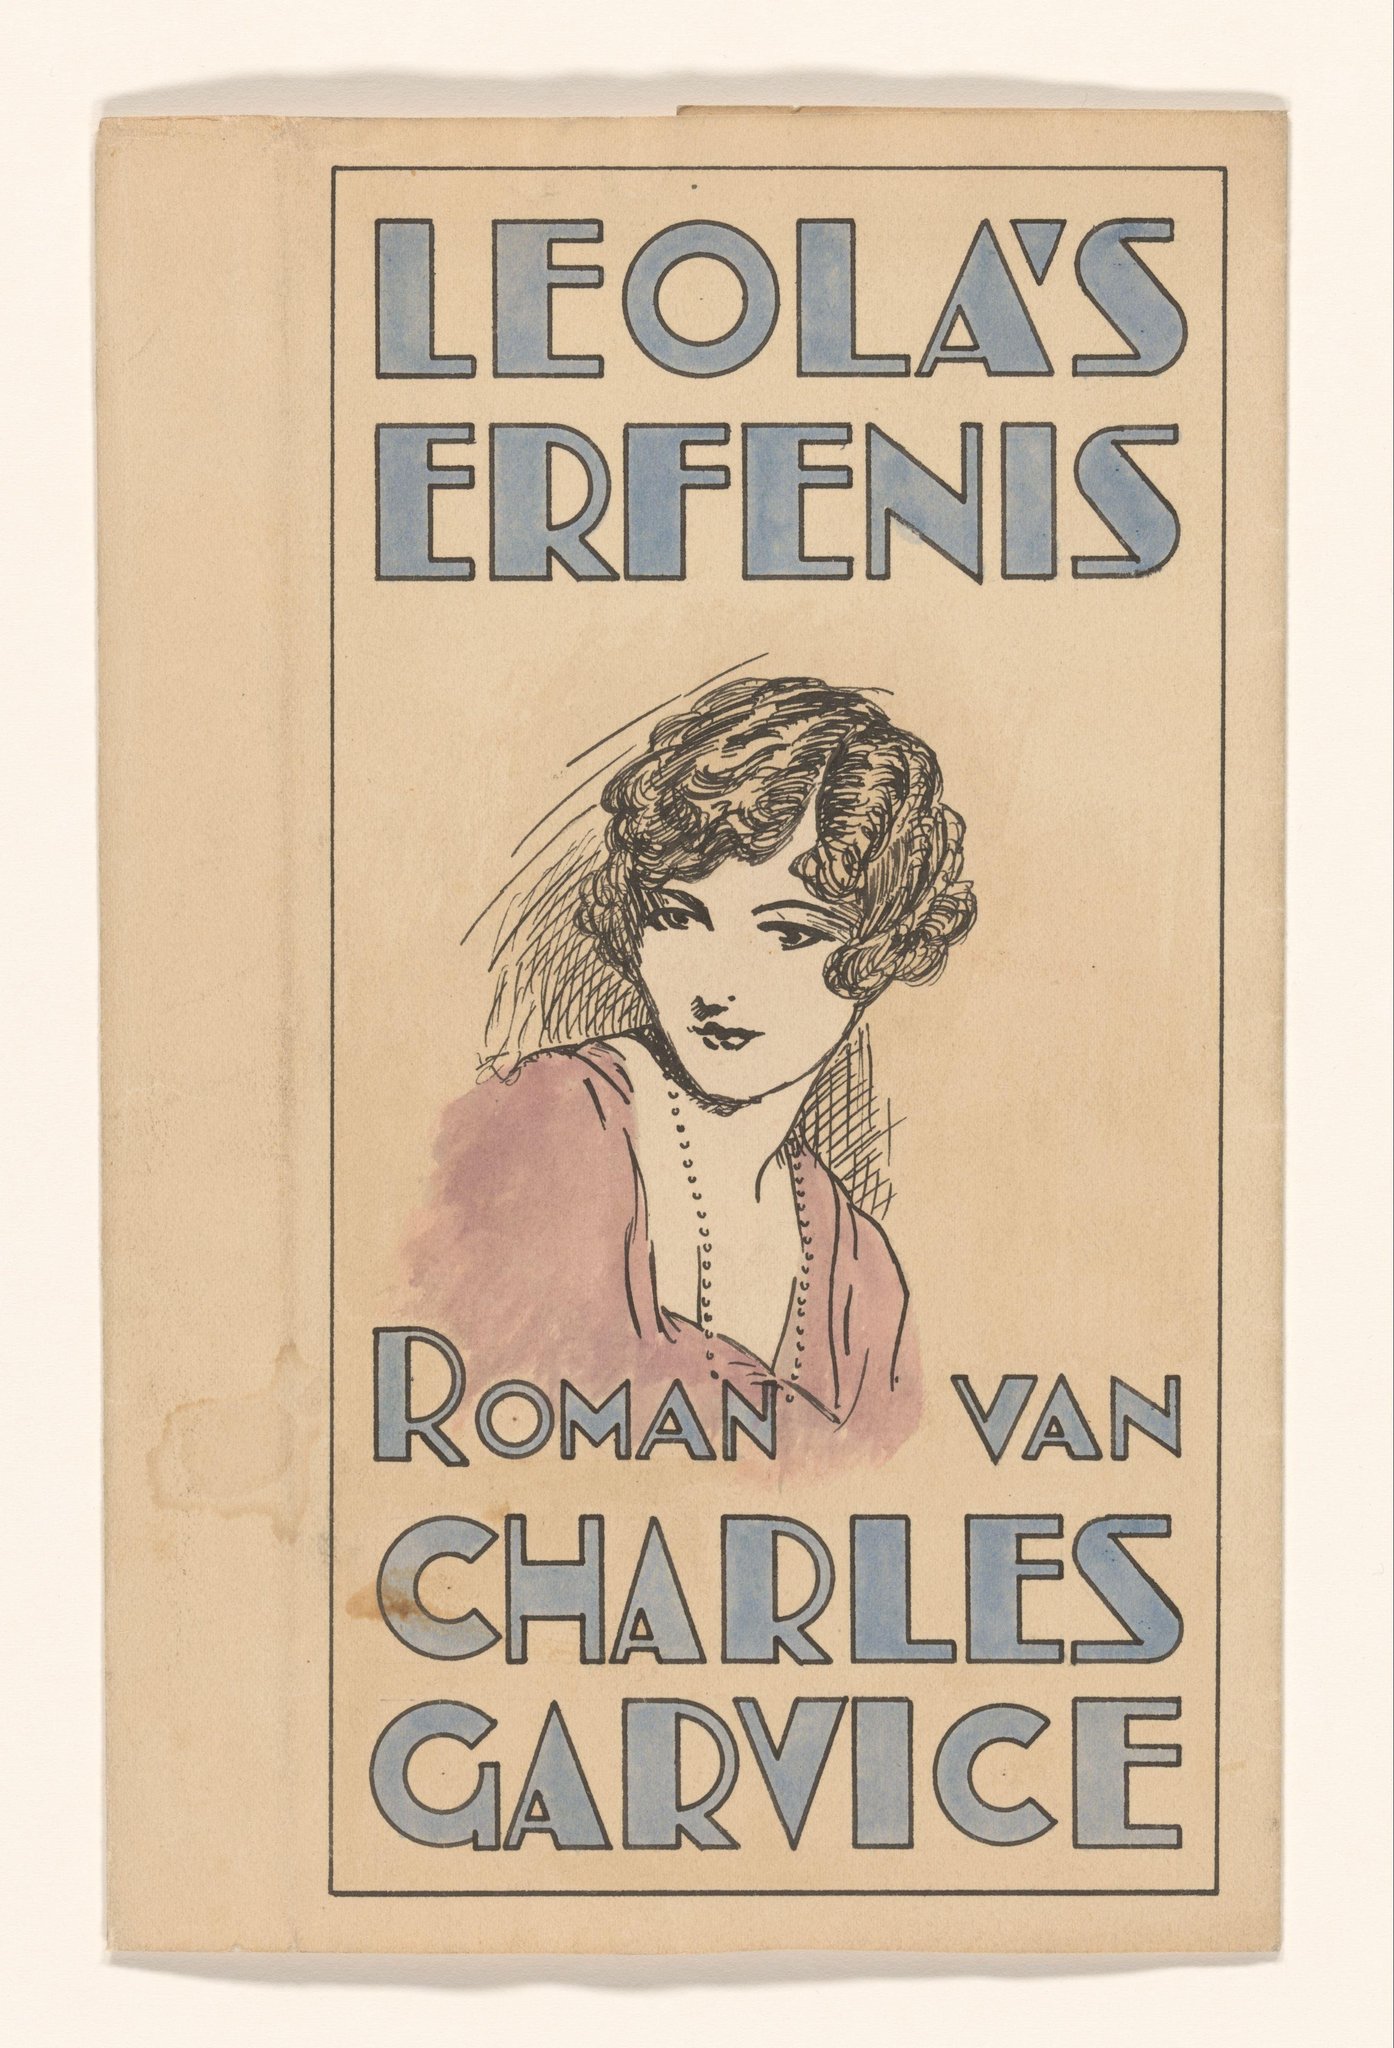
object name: study for binding design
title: Bandontwerp voor: Charles Garvice, Leola's erfenis (Leola Dale's fortune), jaar onbekend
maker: Anonymous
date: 1901-1926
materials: ink, paper, watercolor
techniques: brush, pen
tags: clothing for the upper part of the body: blouse, pearl; pearl necklace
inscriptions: collector's mark: Lugt 2228a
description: Jonge vrouw met kort krullend haar gekleed in een blouse met parelketting.